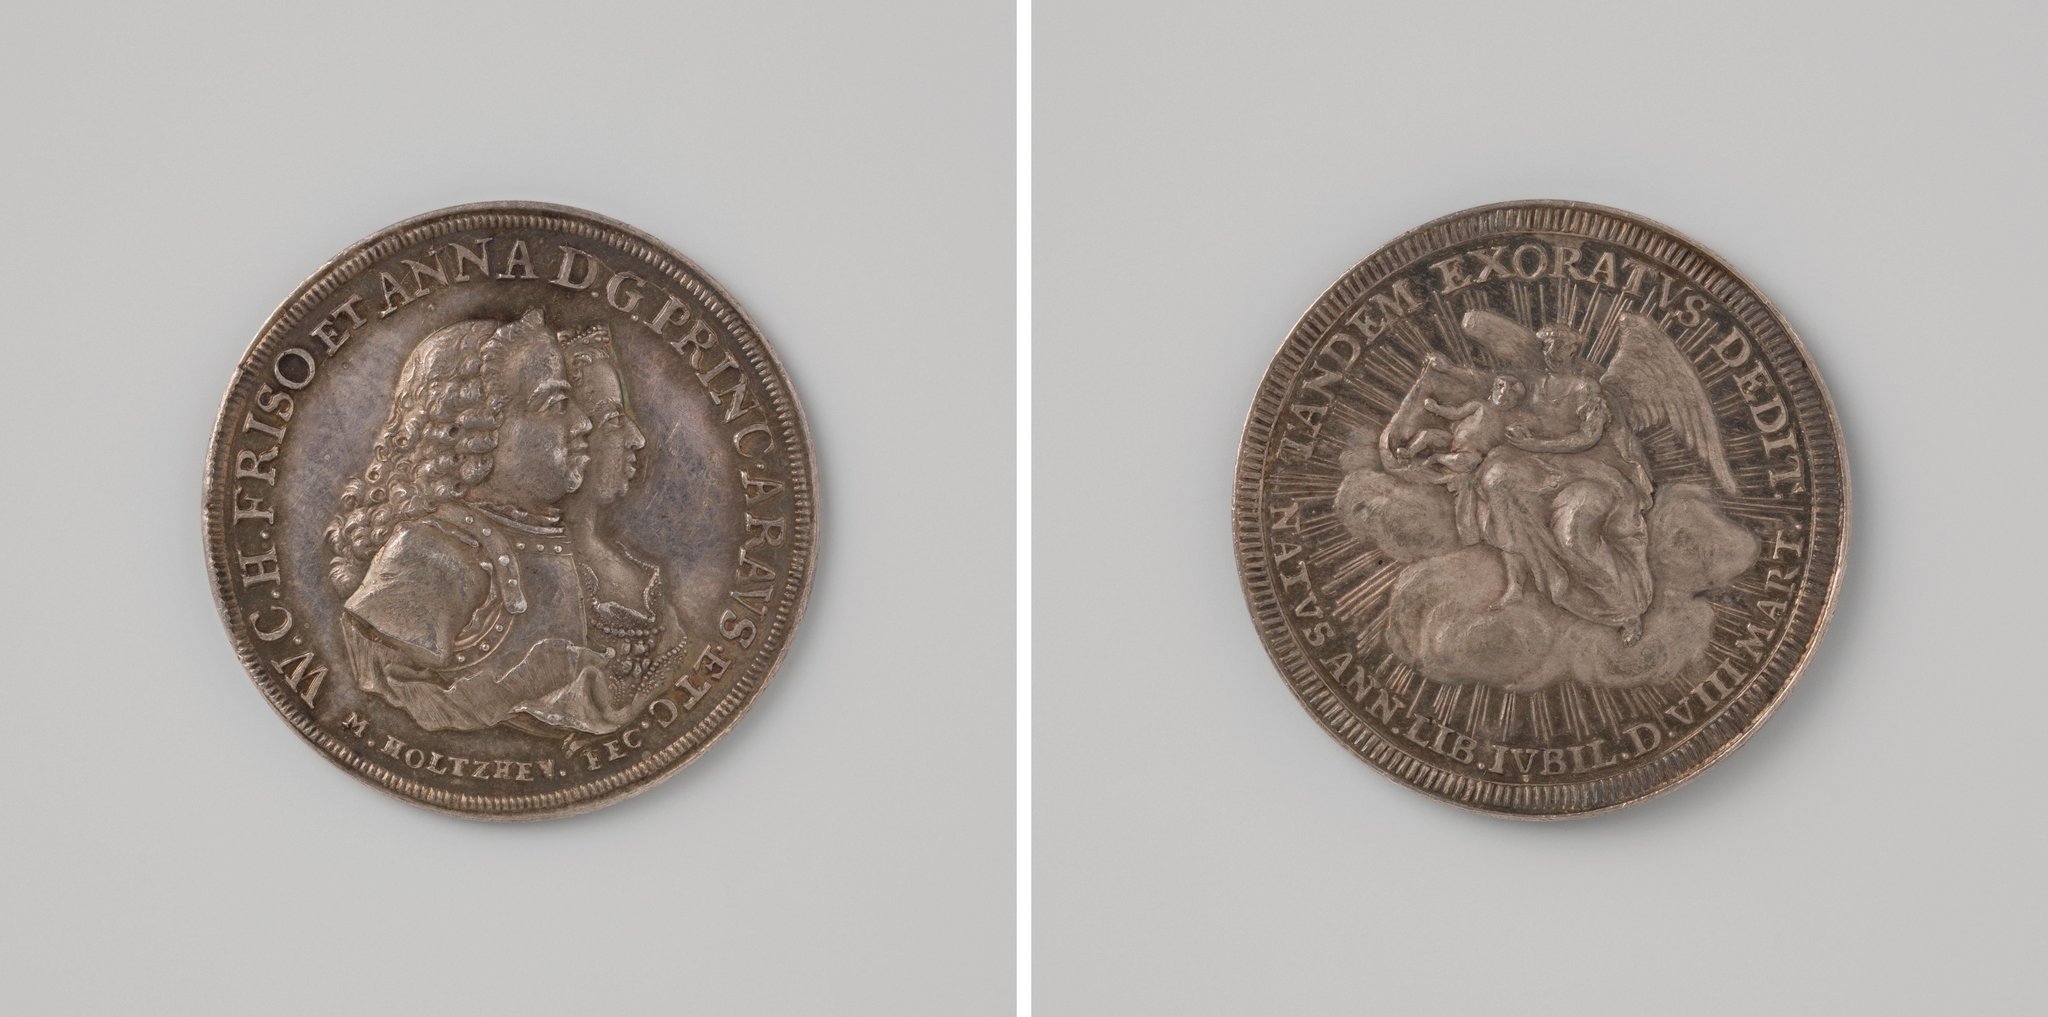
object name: history medal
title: Doop van de erfprins, later stadhouder Willem V 1748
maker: martinus holtzhey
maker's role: medailleur, muntmaker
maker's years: 1697-1764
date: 1748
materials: silver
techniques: striking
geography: amsterdam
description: Zilveren penning, op de voorzijde de geconjugeerde borstbeelden van stadhouder Willem IV en Anna met omschrift, op de keerzijde op een wolk in een stralende hemel een engel die een kind aanreikt, met omschrift.